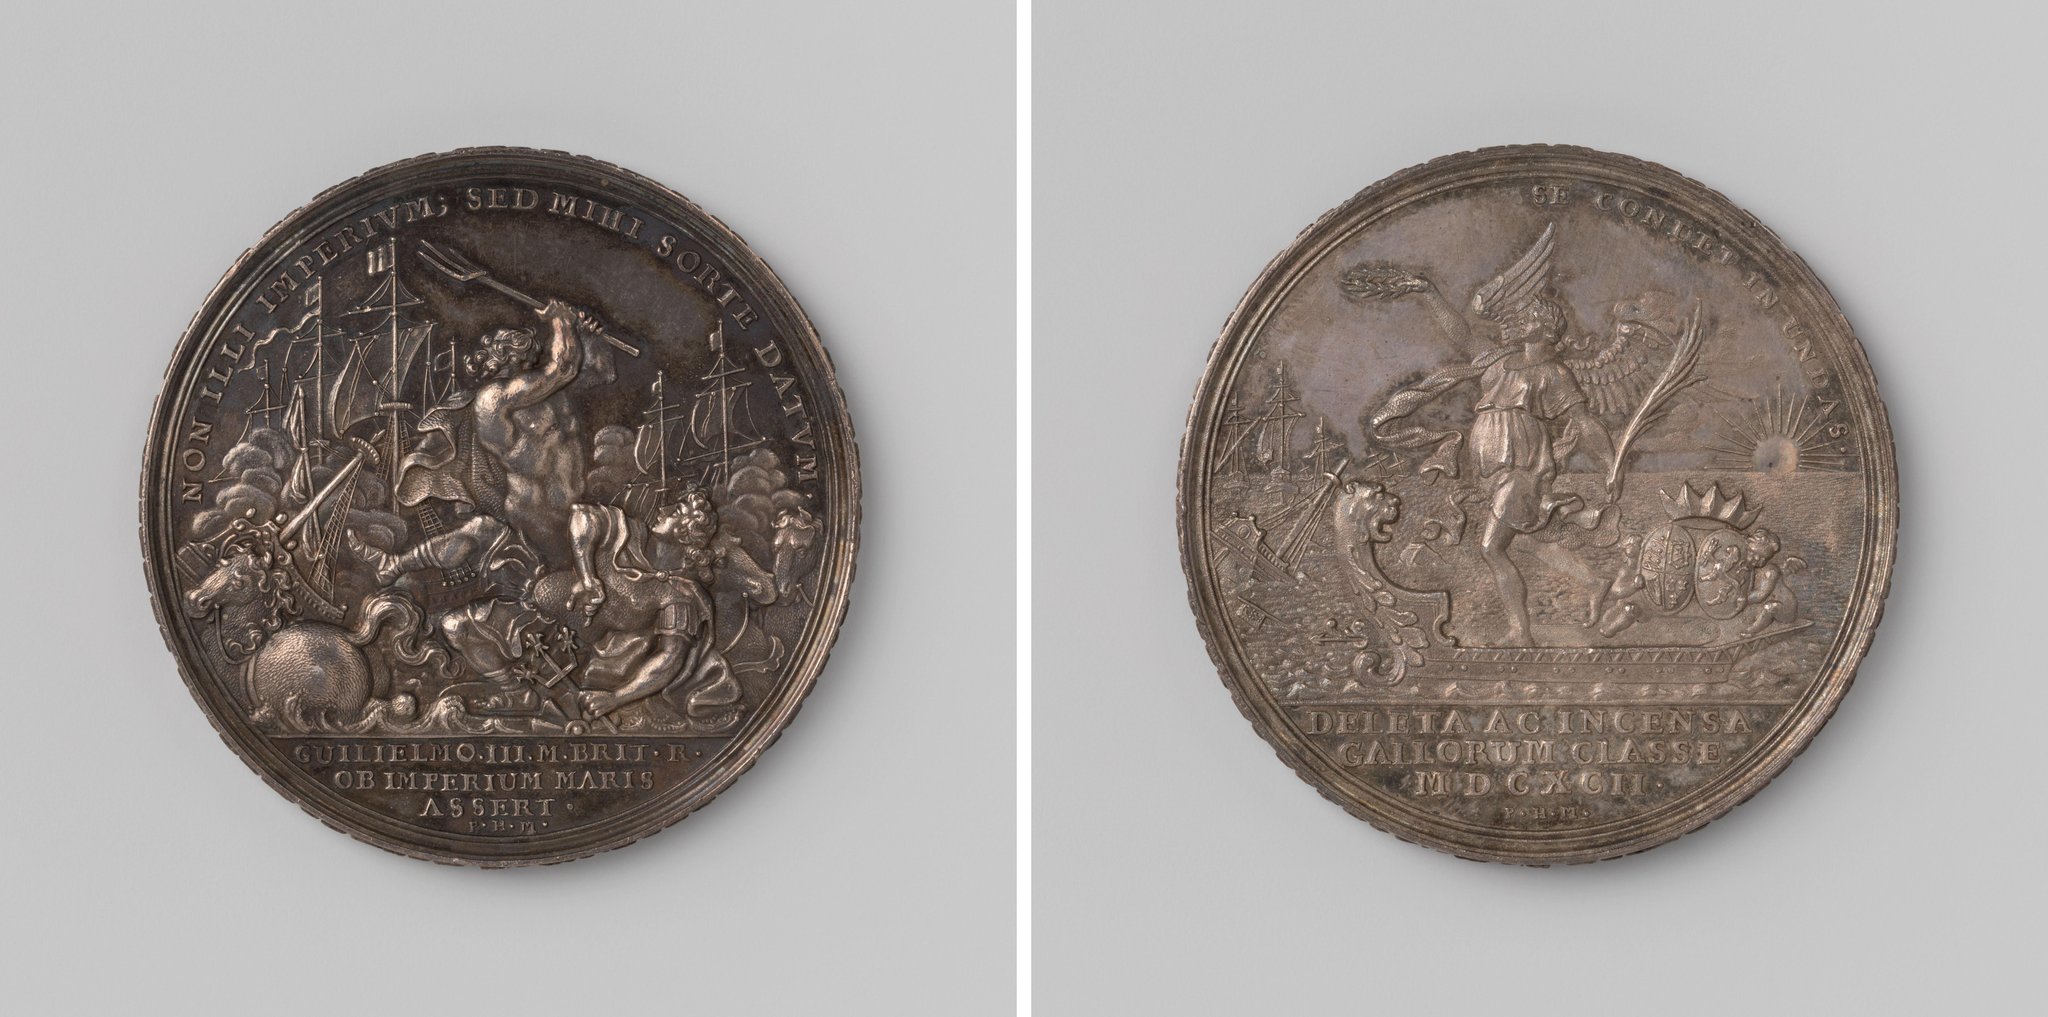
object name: history medal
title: Zeeslag bij Kaap La Hogue, de Fransen verslagen door de vloot van Engeland en Holland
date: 1692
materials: silver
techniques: striking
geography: nuremberg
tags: william iii (prince of orange and king of england, scotland, and ireland)